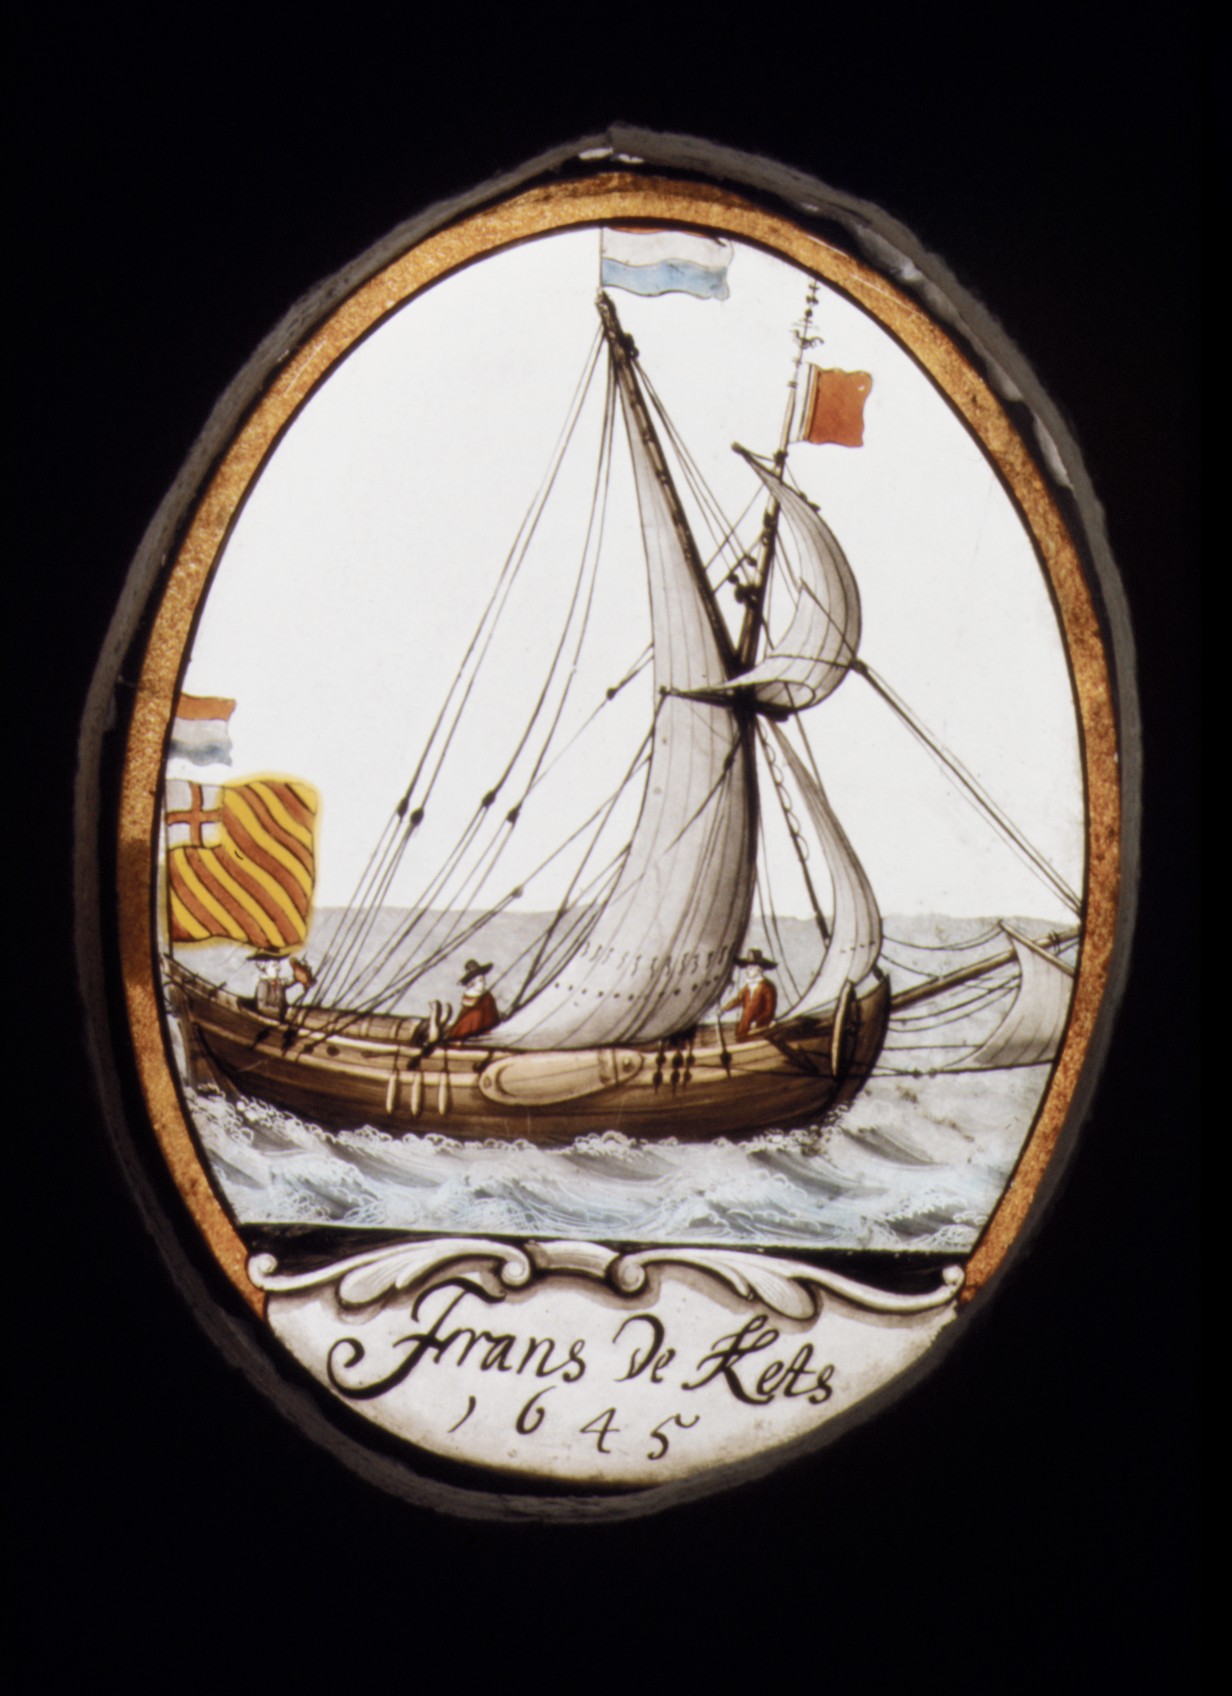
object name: panel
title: Market boat with Dutch flag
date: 1645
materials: glass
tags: men,flags,boats